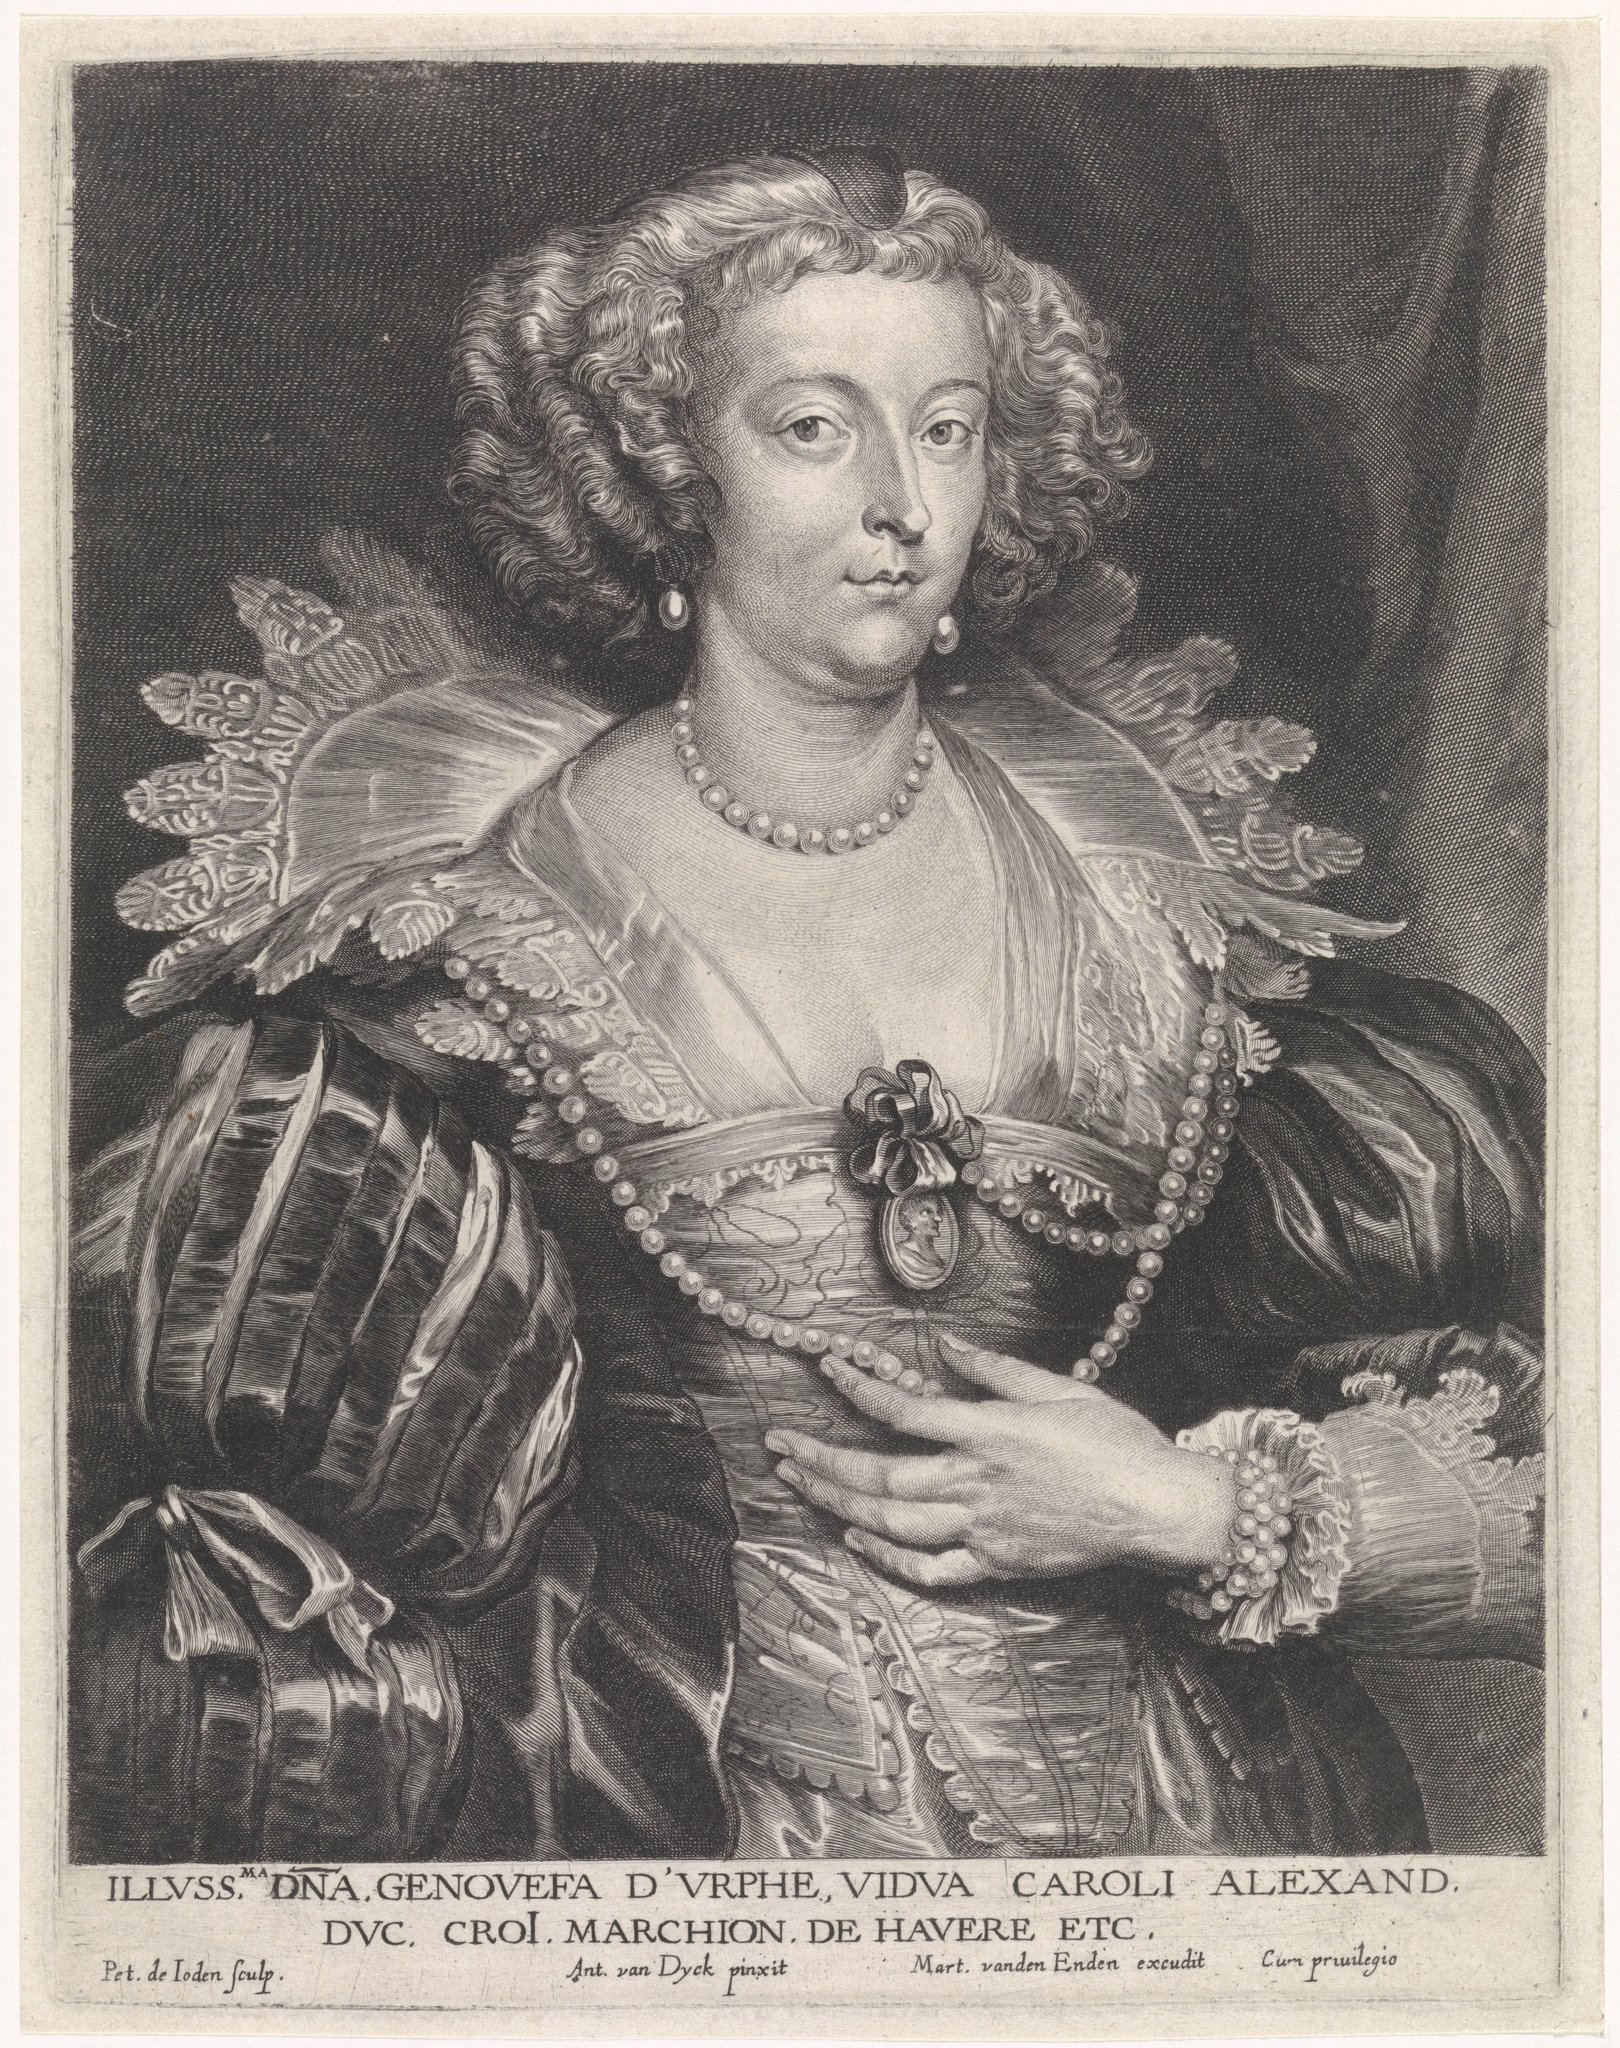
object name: print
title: Portret van Geneviève d'Urfé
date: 1628-1670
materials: paper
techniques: engraving, etching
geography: antwerp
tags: hertogin, geneviève d'urfé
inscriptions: collector's mark: Lugt 240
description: Portret van Geneviève d'Urfé, ten halven lijve. Ze houdt haar linkerhand tegen haar buik. In de marge de naam van de geportretteerde.